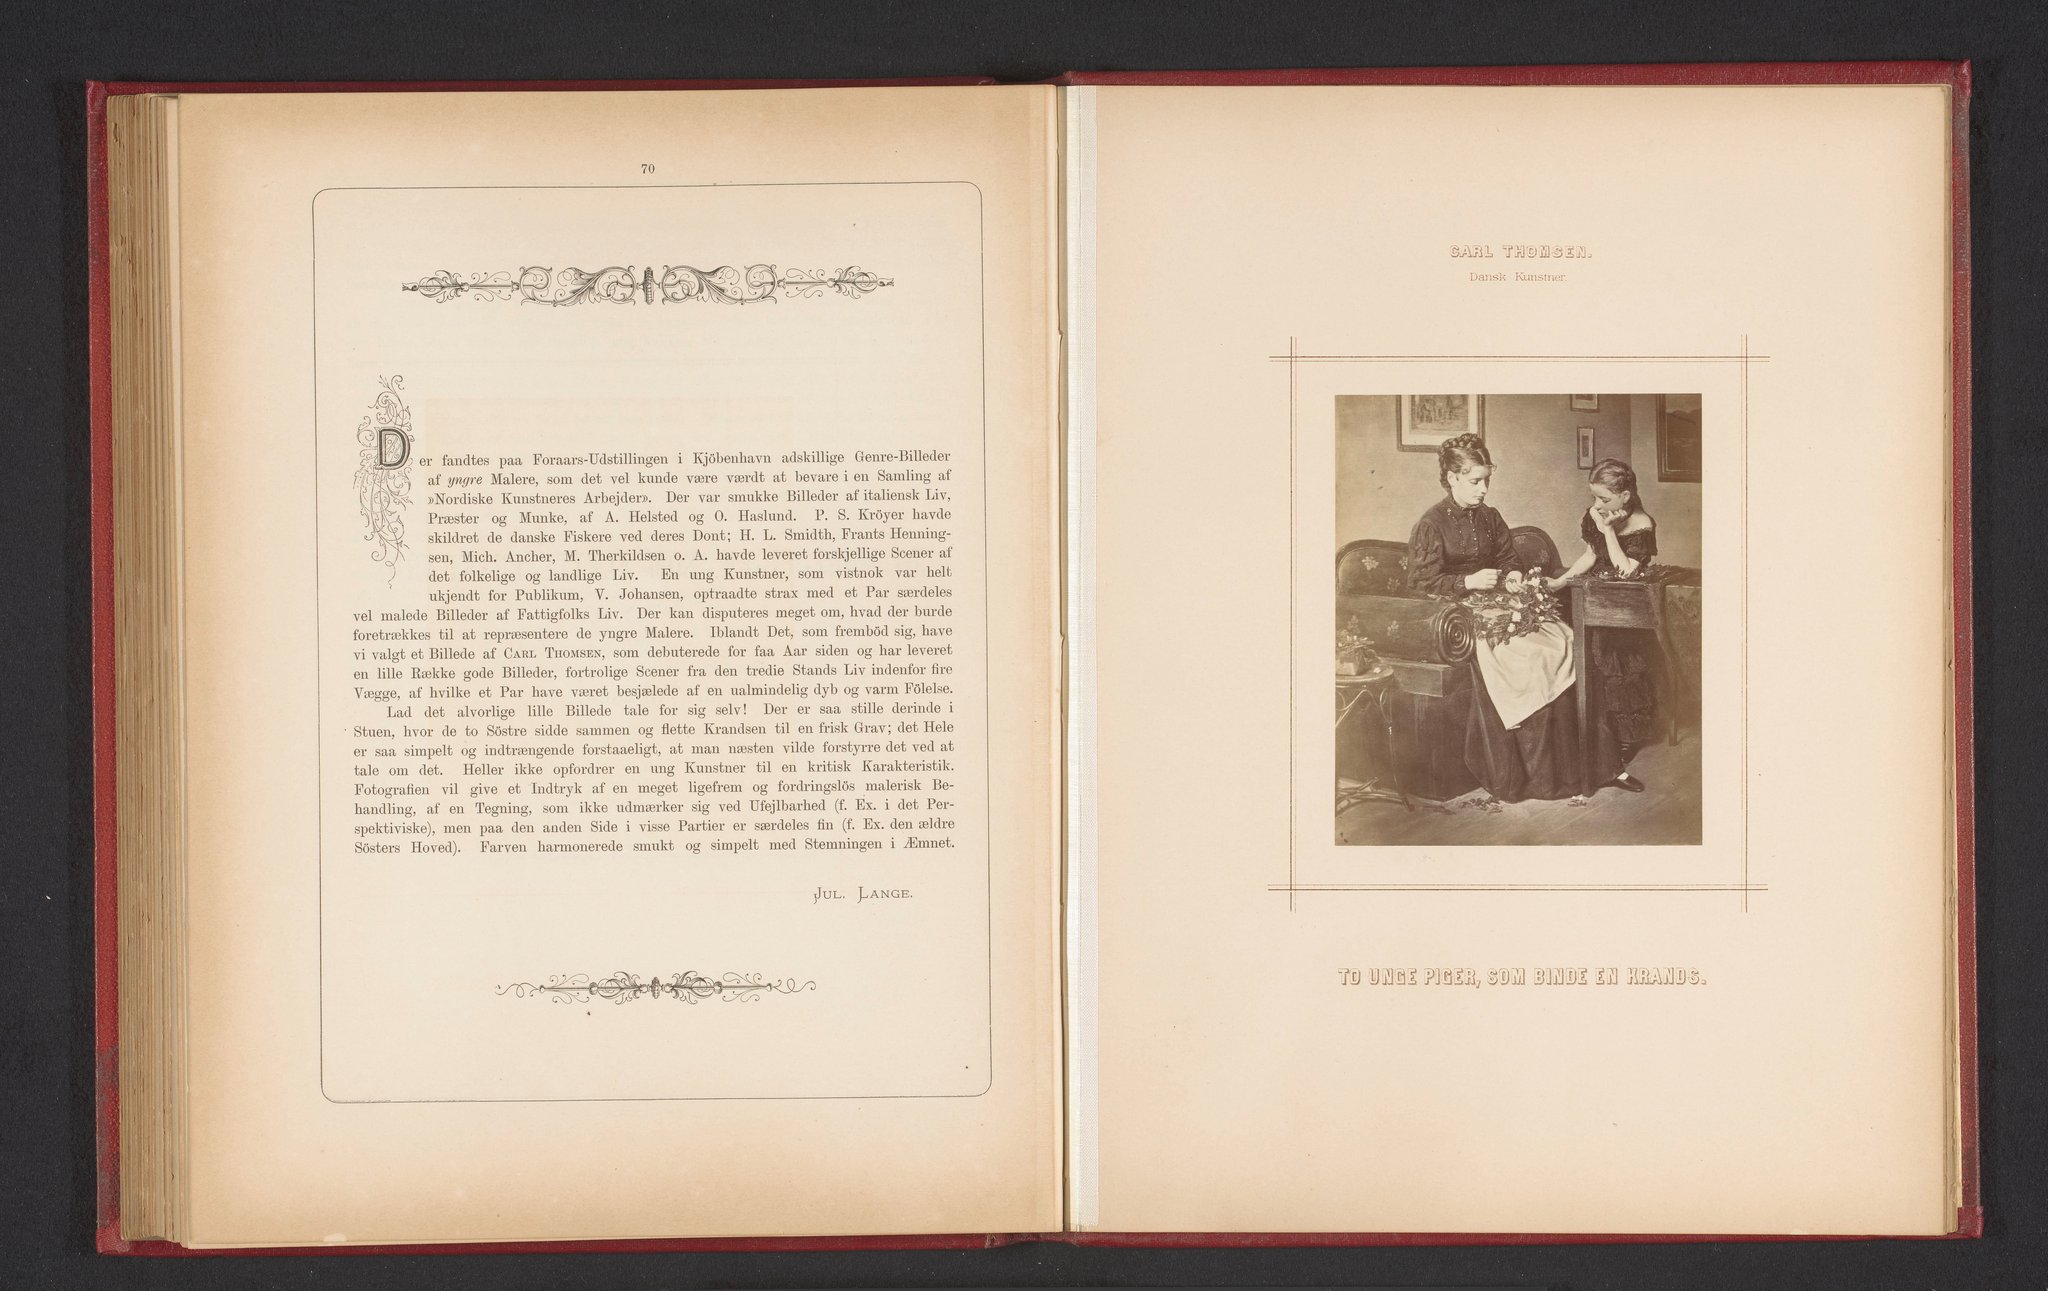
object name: page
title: Fotoreproductie van een schilderij van twee jonge vrouwen die een krans maken door Carl Thomsen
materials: photographic support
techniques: albumen print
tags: adolescent, young woman, maiden, garland, wreath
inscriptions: inscription: ‘Dansk Kunstner.’